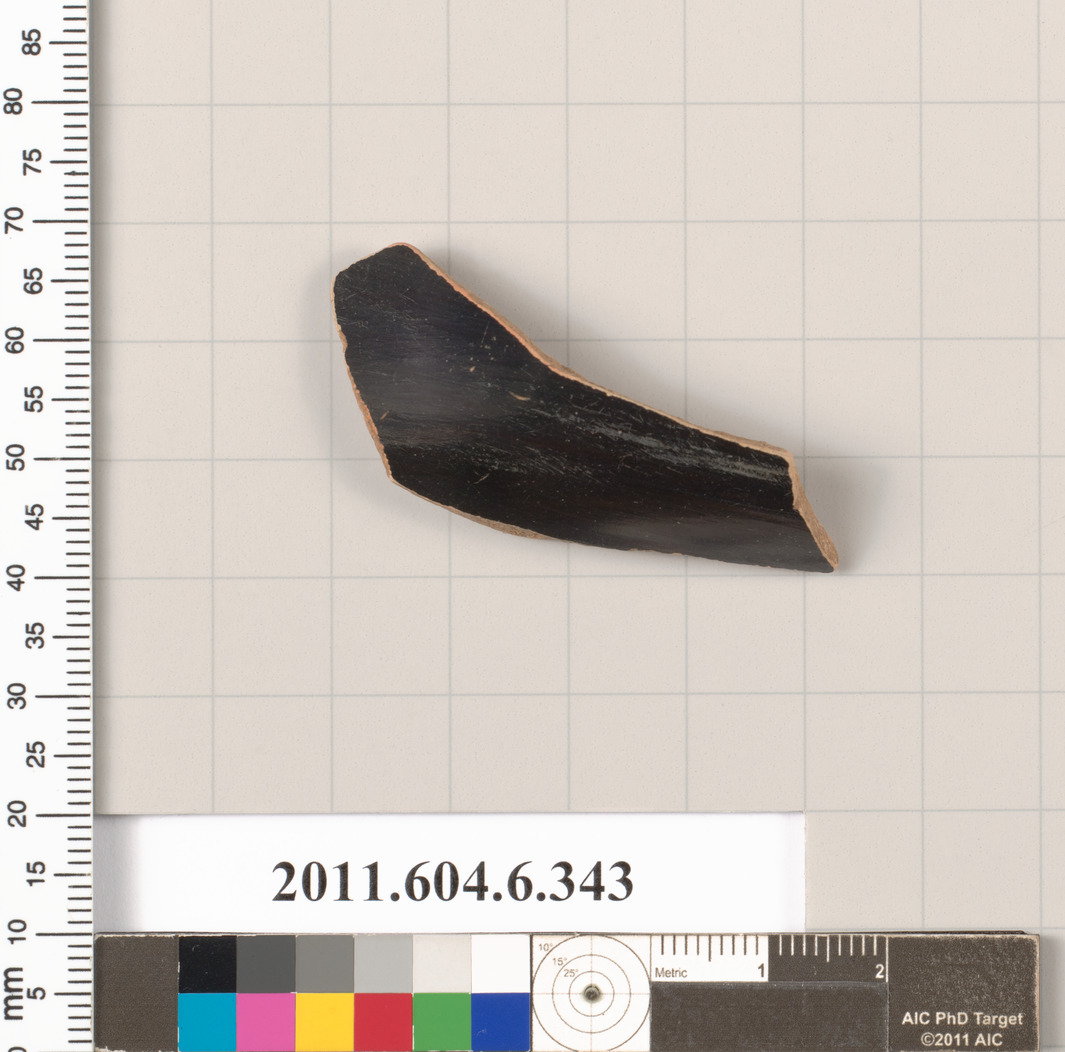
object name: undetermined closed shape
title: Terracotta fragment of a closed shape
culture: greek, attic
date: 600-401 BCE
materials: terracotta